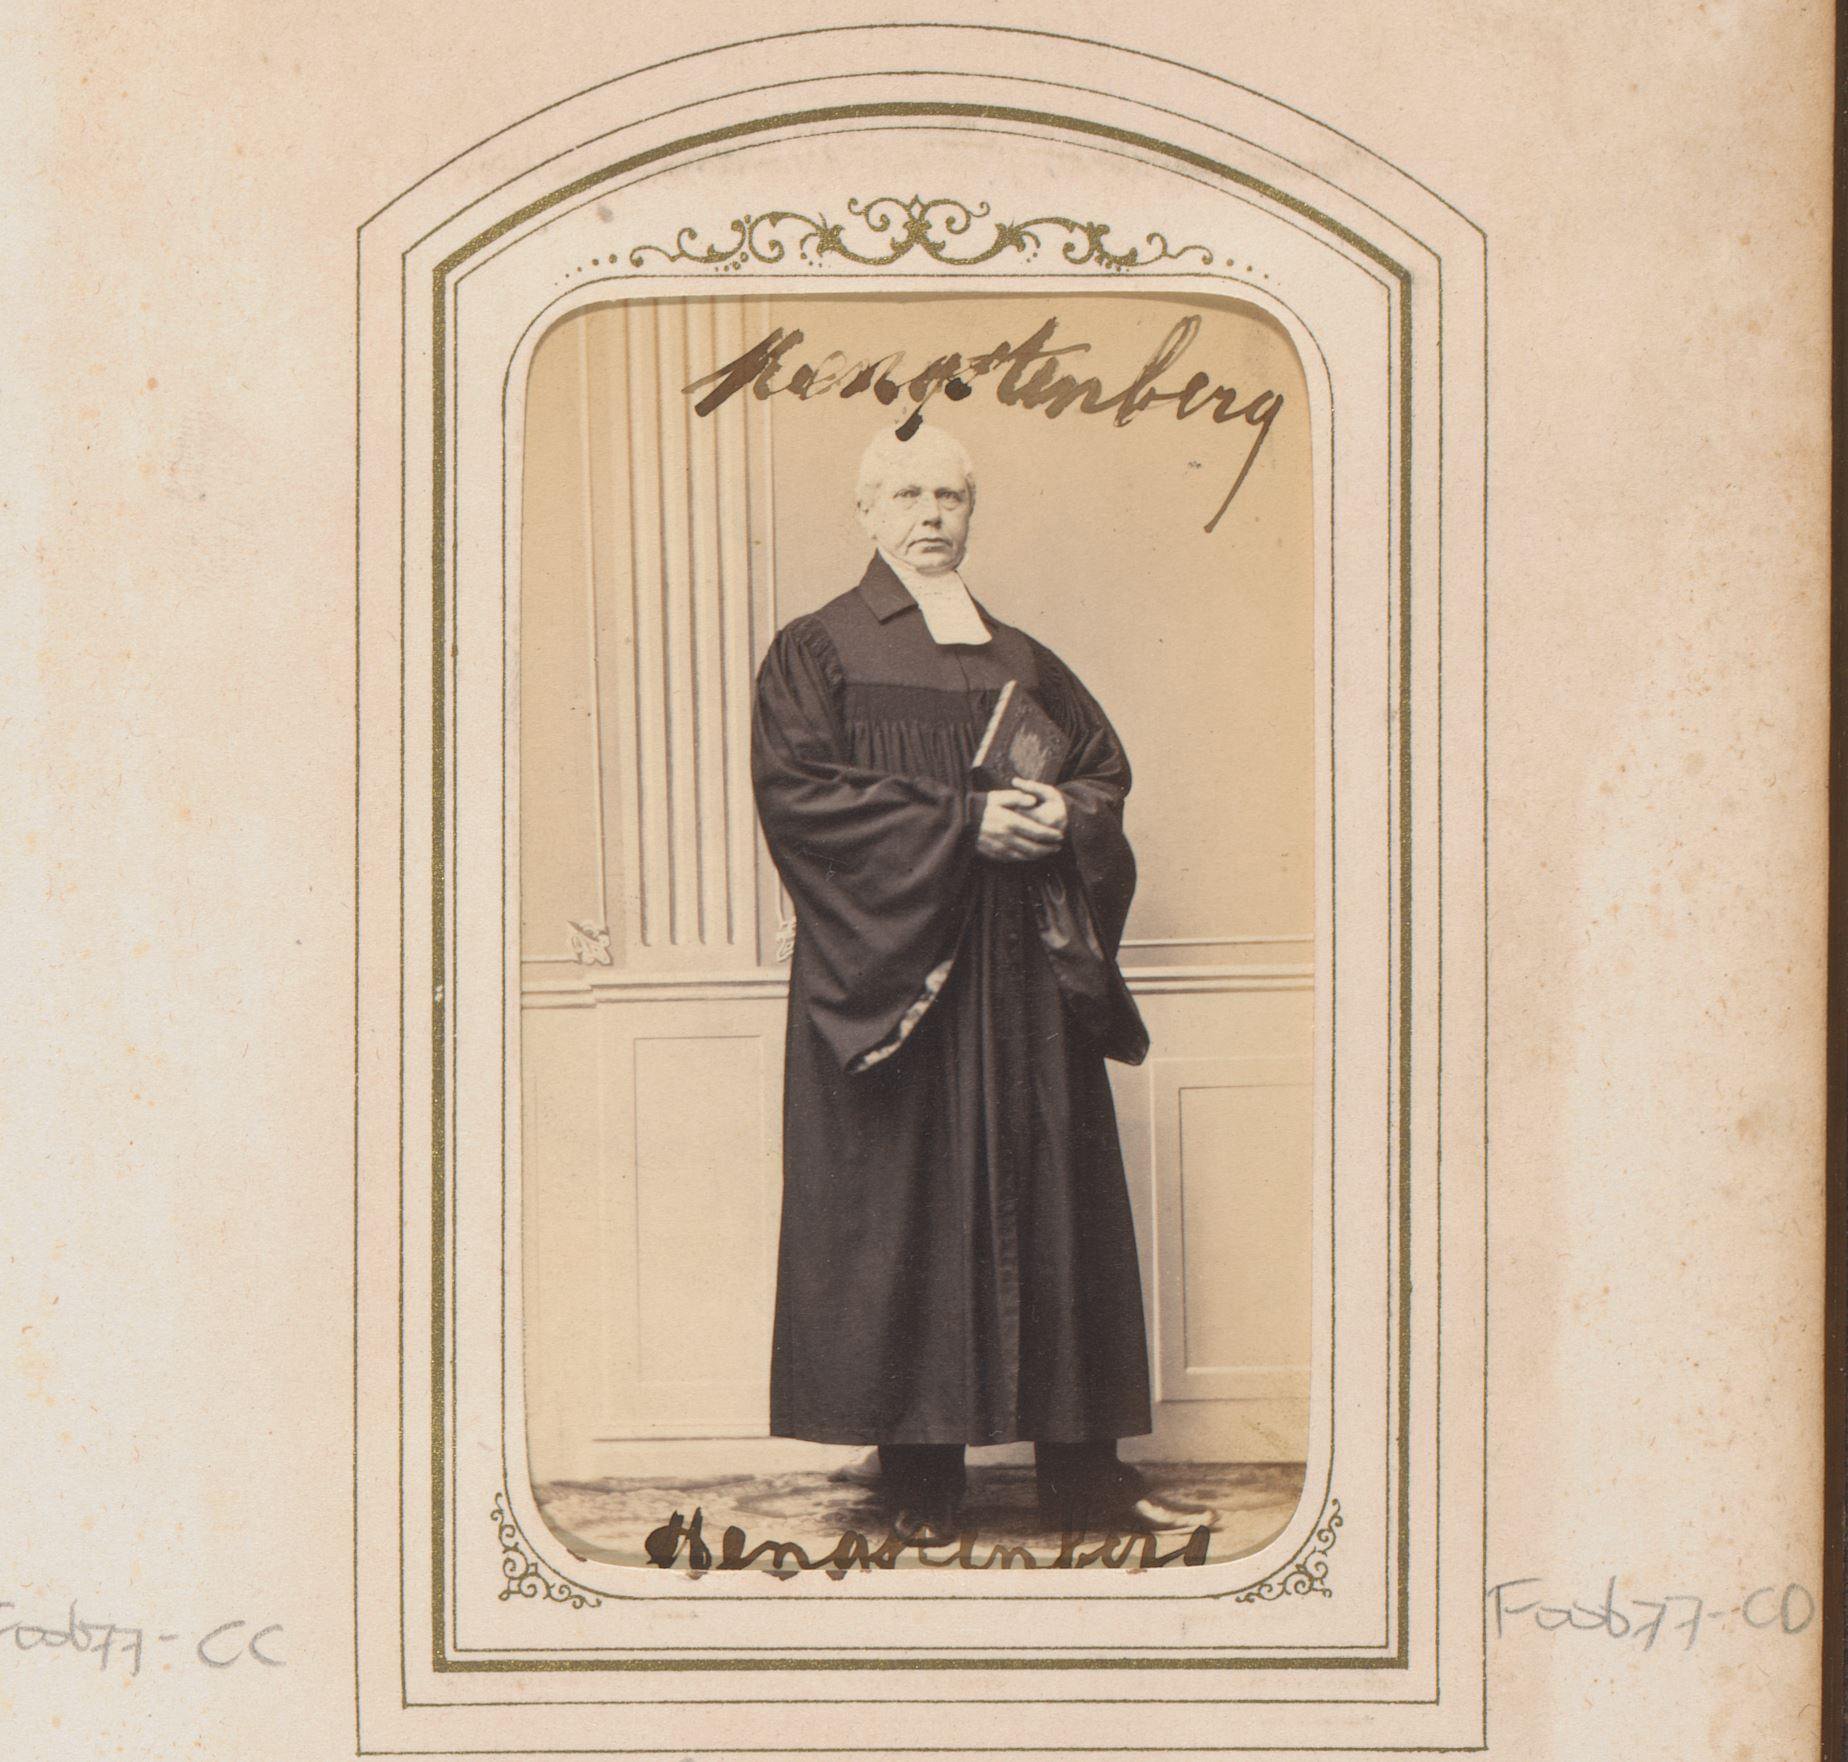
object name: album leaf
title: Portret Ernst Wilhelm Hengstenberg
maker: albert grundner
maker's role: fotograaf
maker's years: 1825-1889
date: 1862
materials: cardboard, photographic support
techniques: albumen print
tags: theologian, historical persons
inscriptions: name: ‘Hengstenberg’, inscription: ‘ALBERT GRUNDNER/ PHOTOGRAPH/ BERLIN/ Leipziger Str. 67./ von Mitte Juli d. J. befindet/ sich mein Atelier/ Leipziger Str. 50/ 2de Haus von der Jerusalemer-Str.’, name: ‘Hengstenberg’, annotation: ‘E. W. Hengstenberg 1802/68’